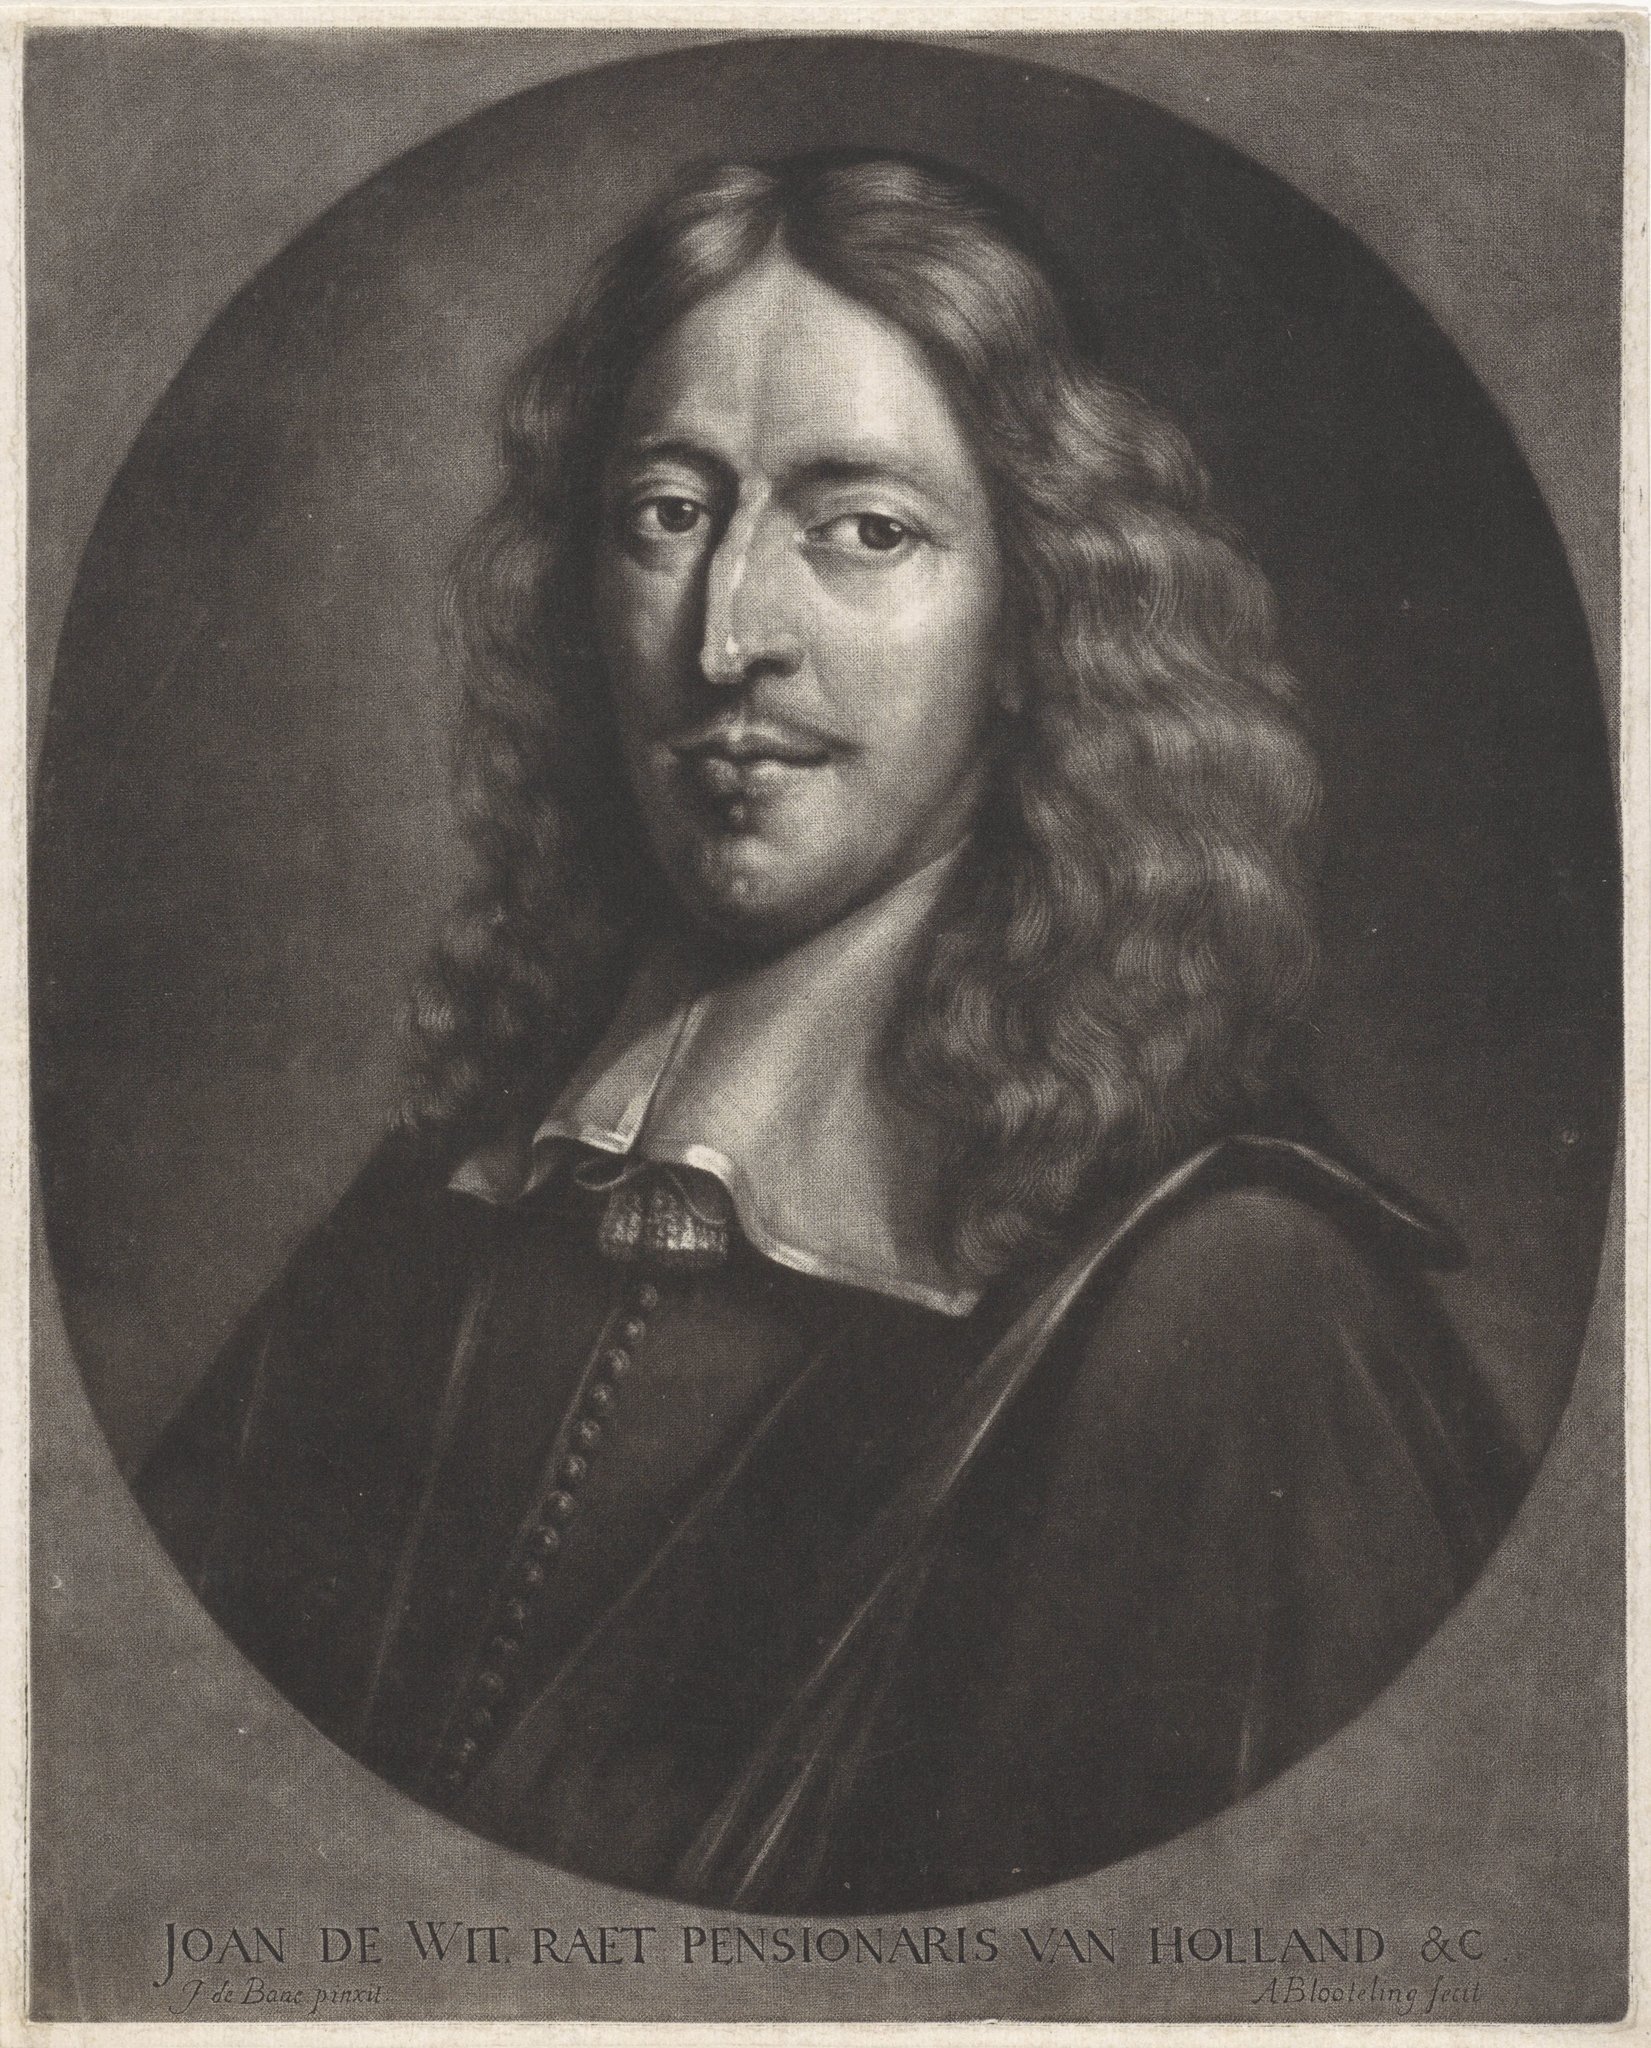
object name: print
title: Portret van Johan de Witt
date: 1660-1690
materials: paper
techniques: engraving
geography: amsterdam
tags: johan de witt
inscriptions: collector's mark: Lugt 2228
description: Portret van de advocaat Johan de Witt, raadspensionaris van het gewest Holland.